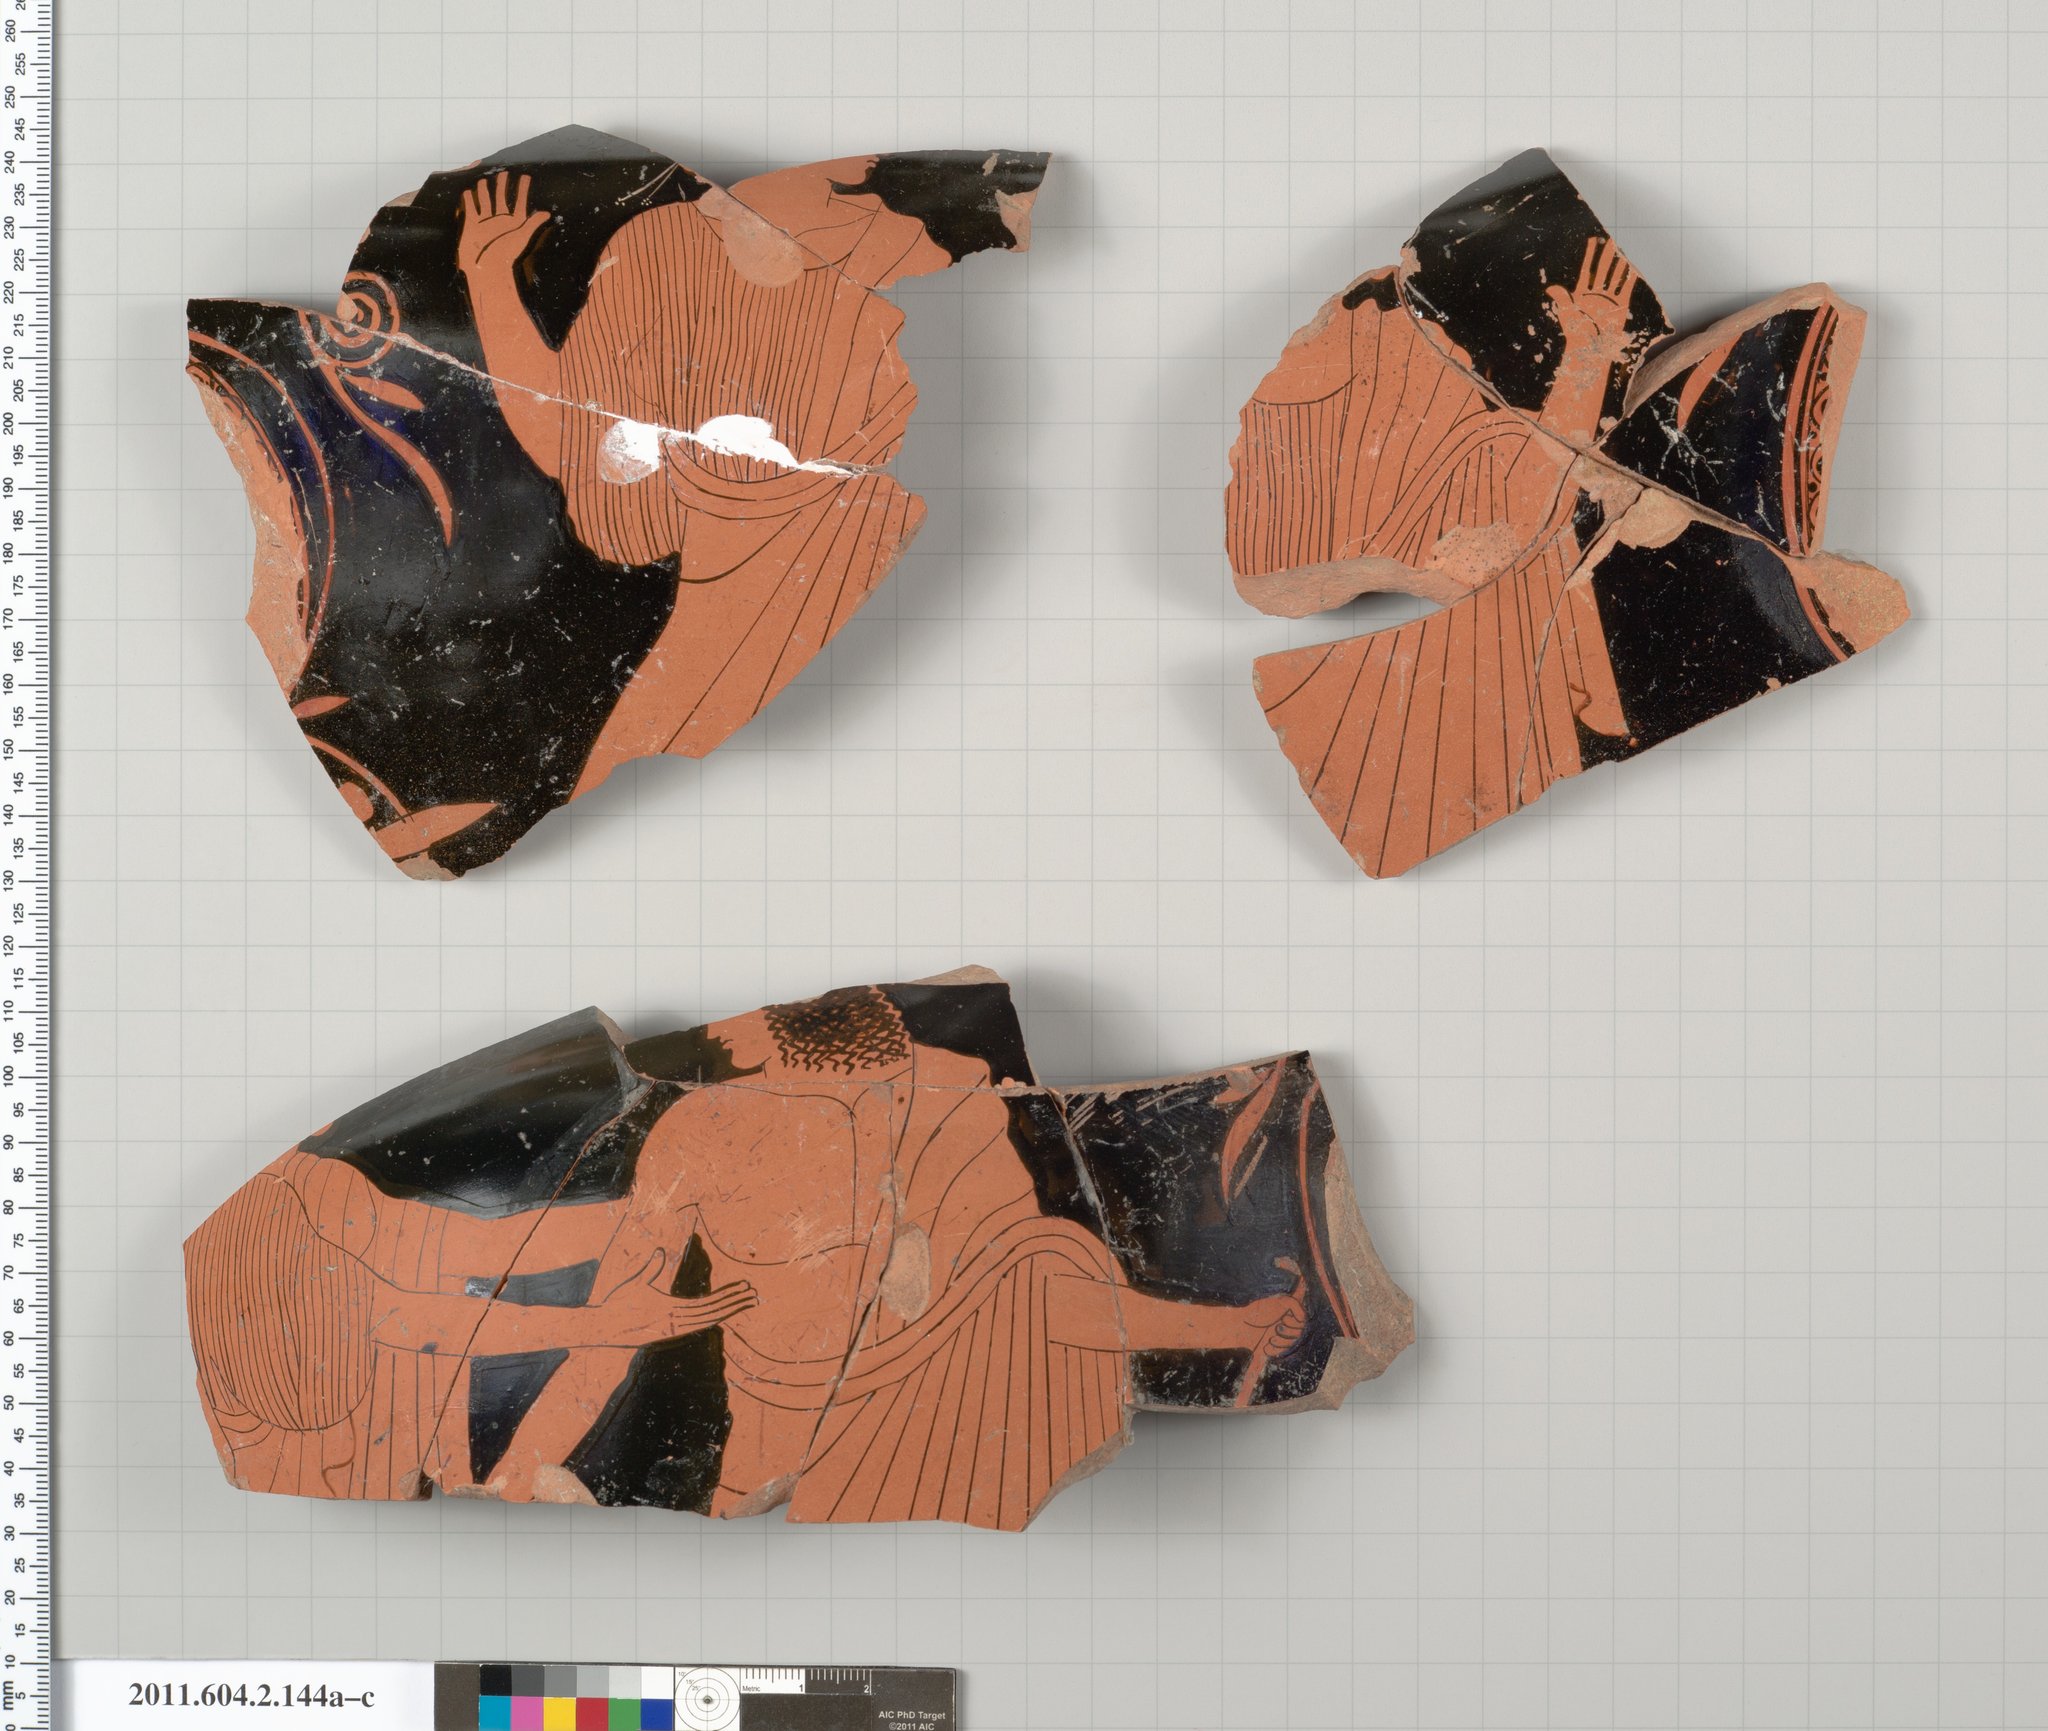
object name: stamnos fragment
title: Terracotta fragments of a stamnos (jar)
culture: greek, attic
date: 470-460 BCE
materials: terracotta